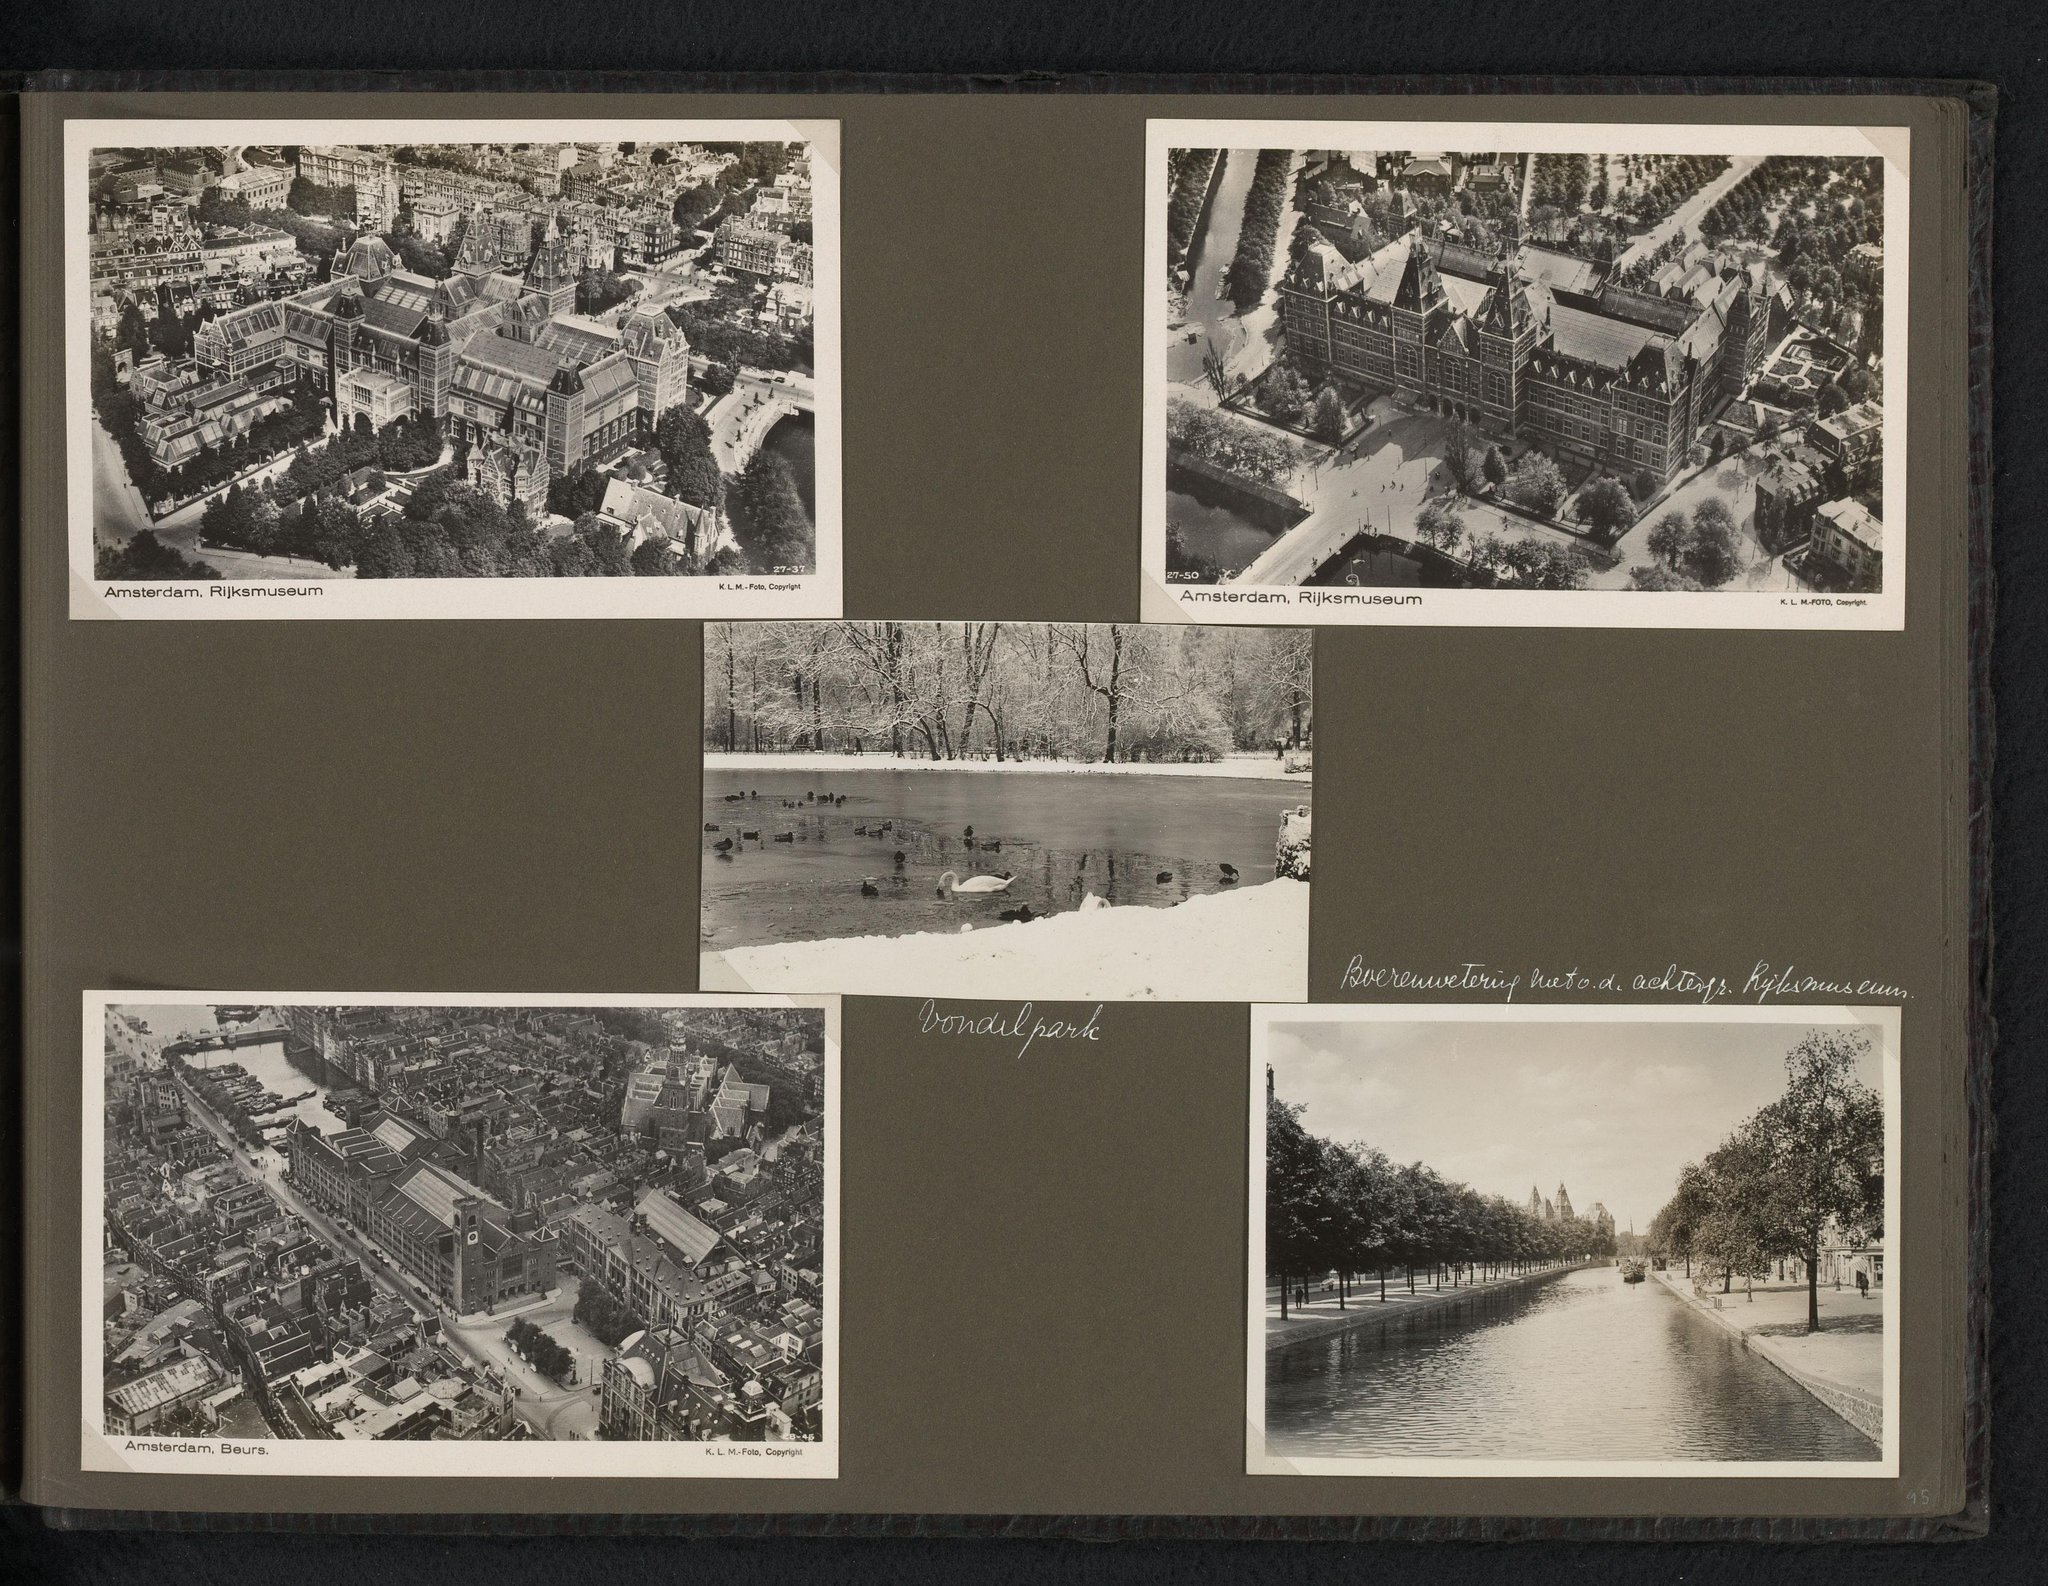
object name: aerial photograph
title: Vijf foto's van het Rijksmuseum, Vondelpark, de Beurs van Berlage en de Boerenwetering in Amsterdam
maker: frank willem van den berg (1912-1998)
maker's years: 1912-1998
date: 1930-1934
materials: paper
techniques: gelatin silver print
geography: amsterdam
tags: park, stock exchange, stock-market, canals, waters (in city), permanent exhibition, museum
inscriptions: inscription: ‘Amsterdam, Beurs’, inscription: ‘Boerenwetering met o.d. achtergr. Rijksmuseum’, inscription: ‘Vondelpark’, inscription: ‘Amsterdam, Rijksmuseum’, inscription: ‘Amsterdam, Rijksmuseum’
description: Deze foto's maken deel uit van een album.